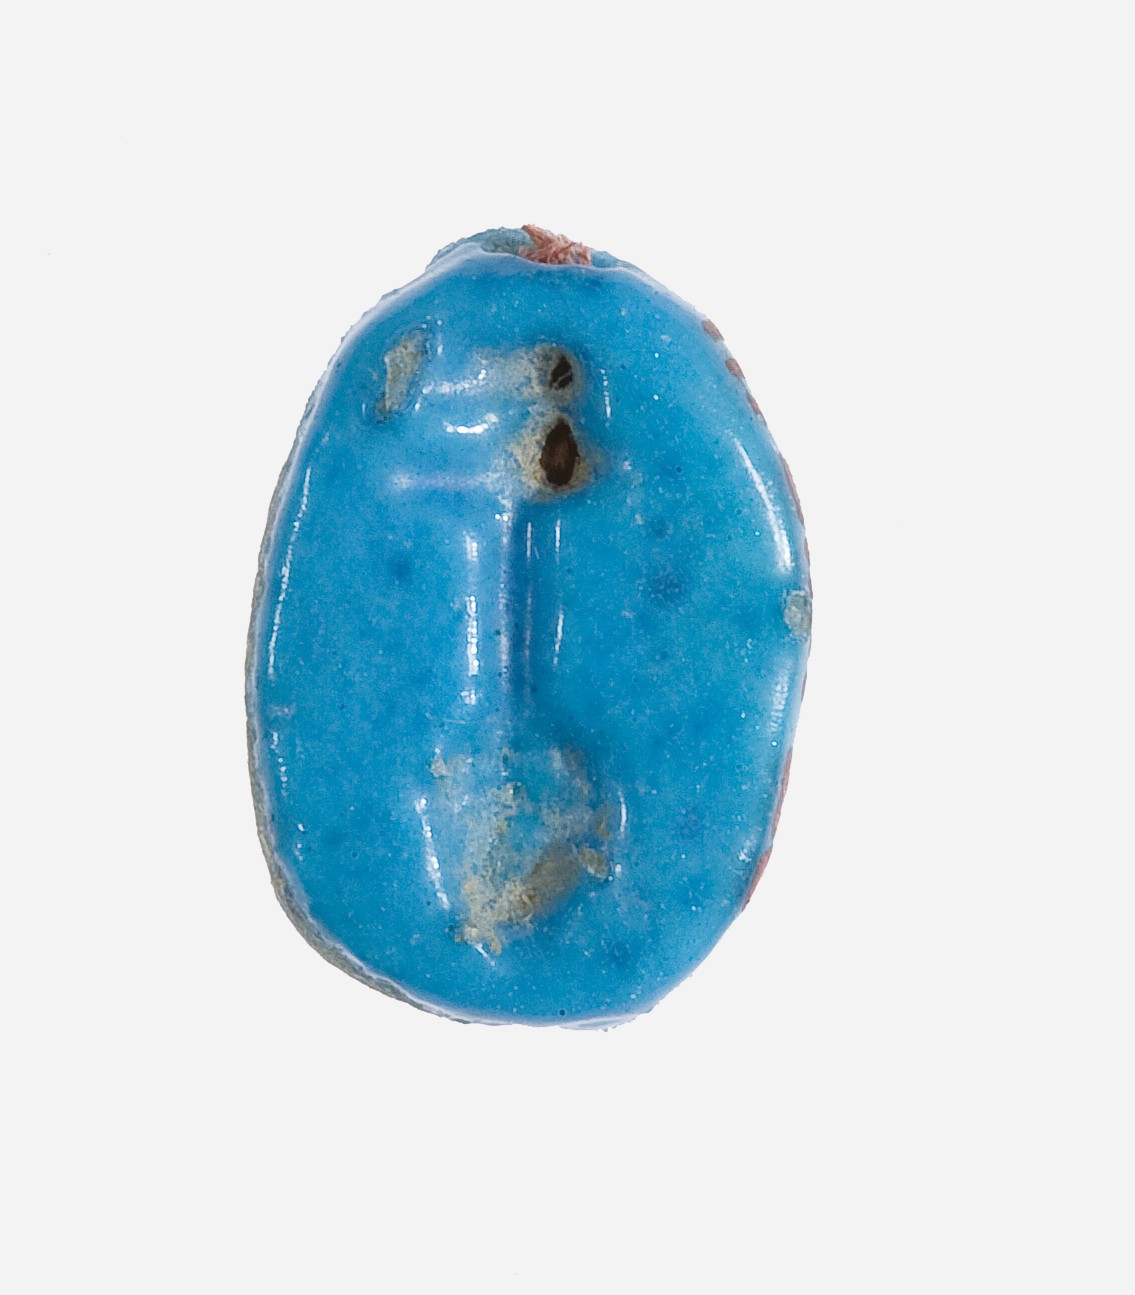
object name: scarab, nefer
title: Scarab with a Nefer Hieroglyph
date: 1390-1352 BCE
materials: faience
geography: egypt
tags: hieroglyphs,scarabs